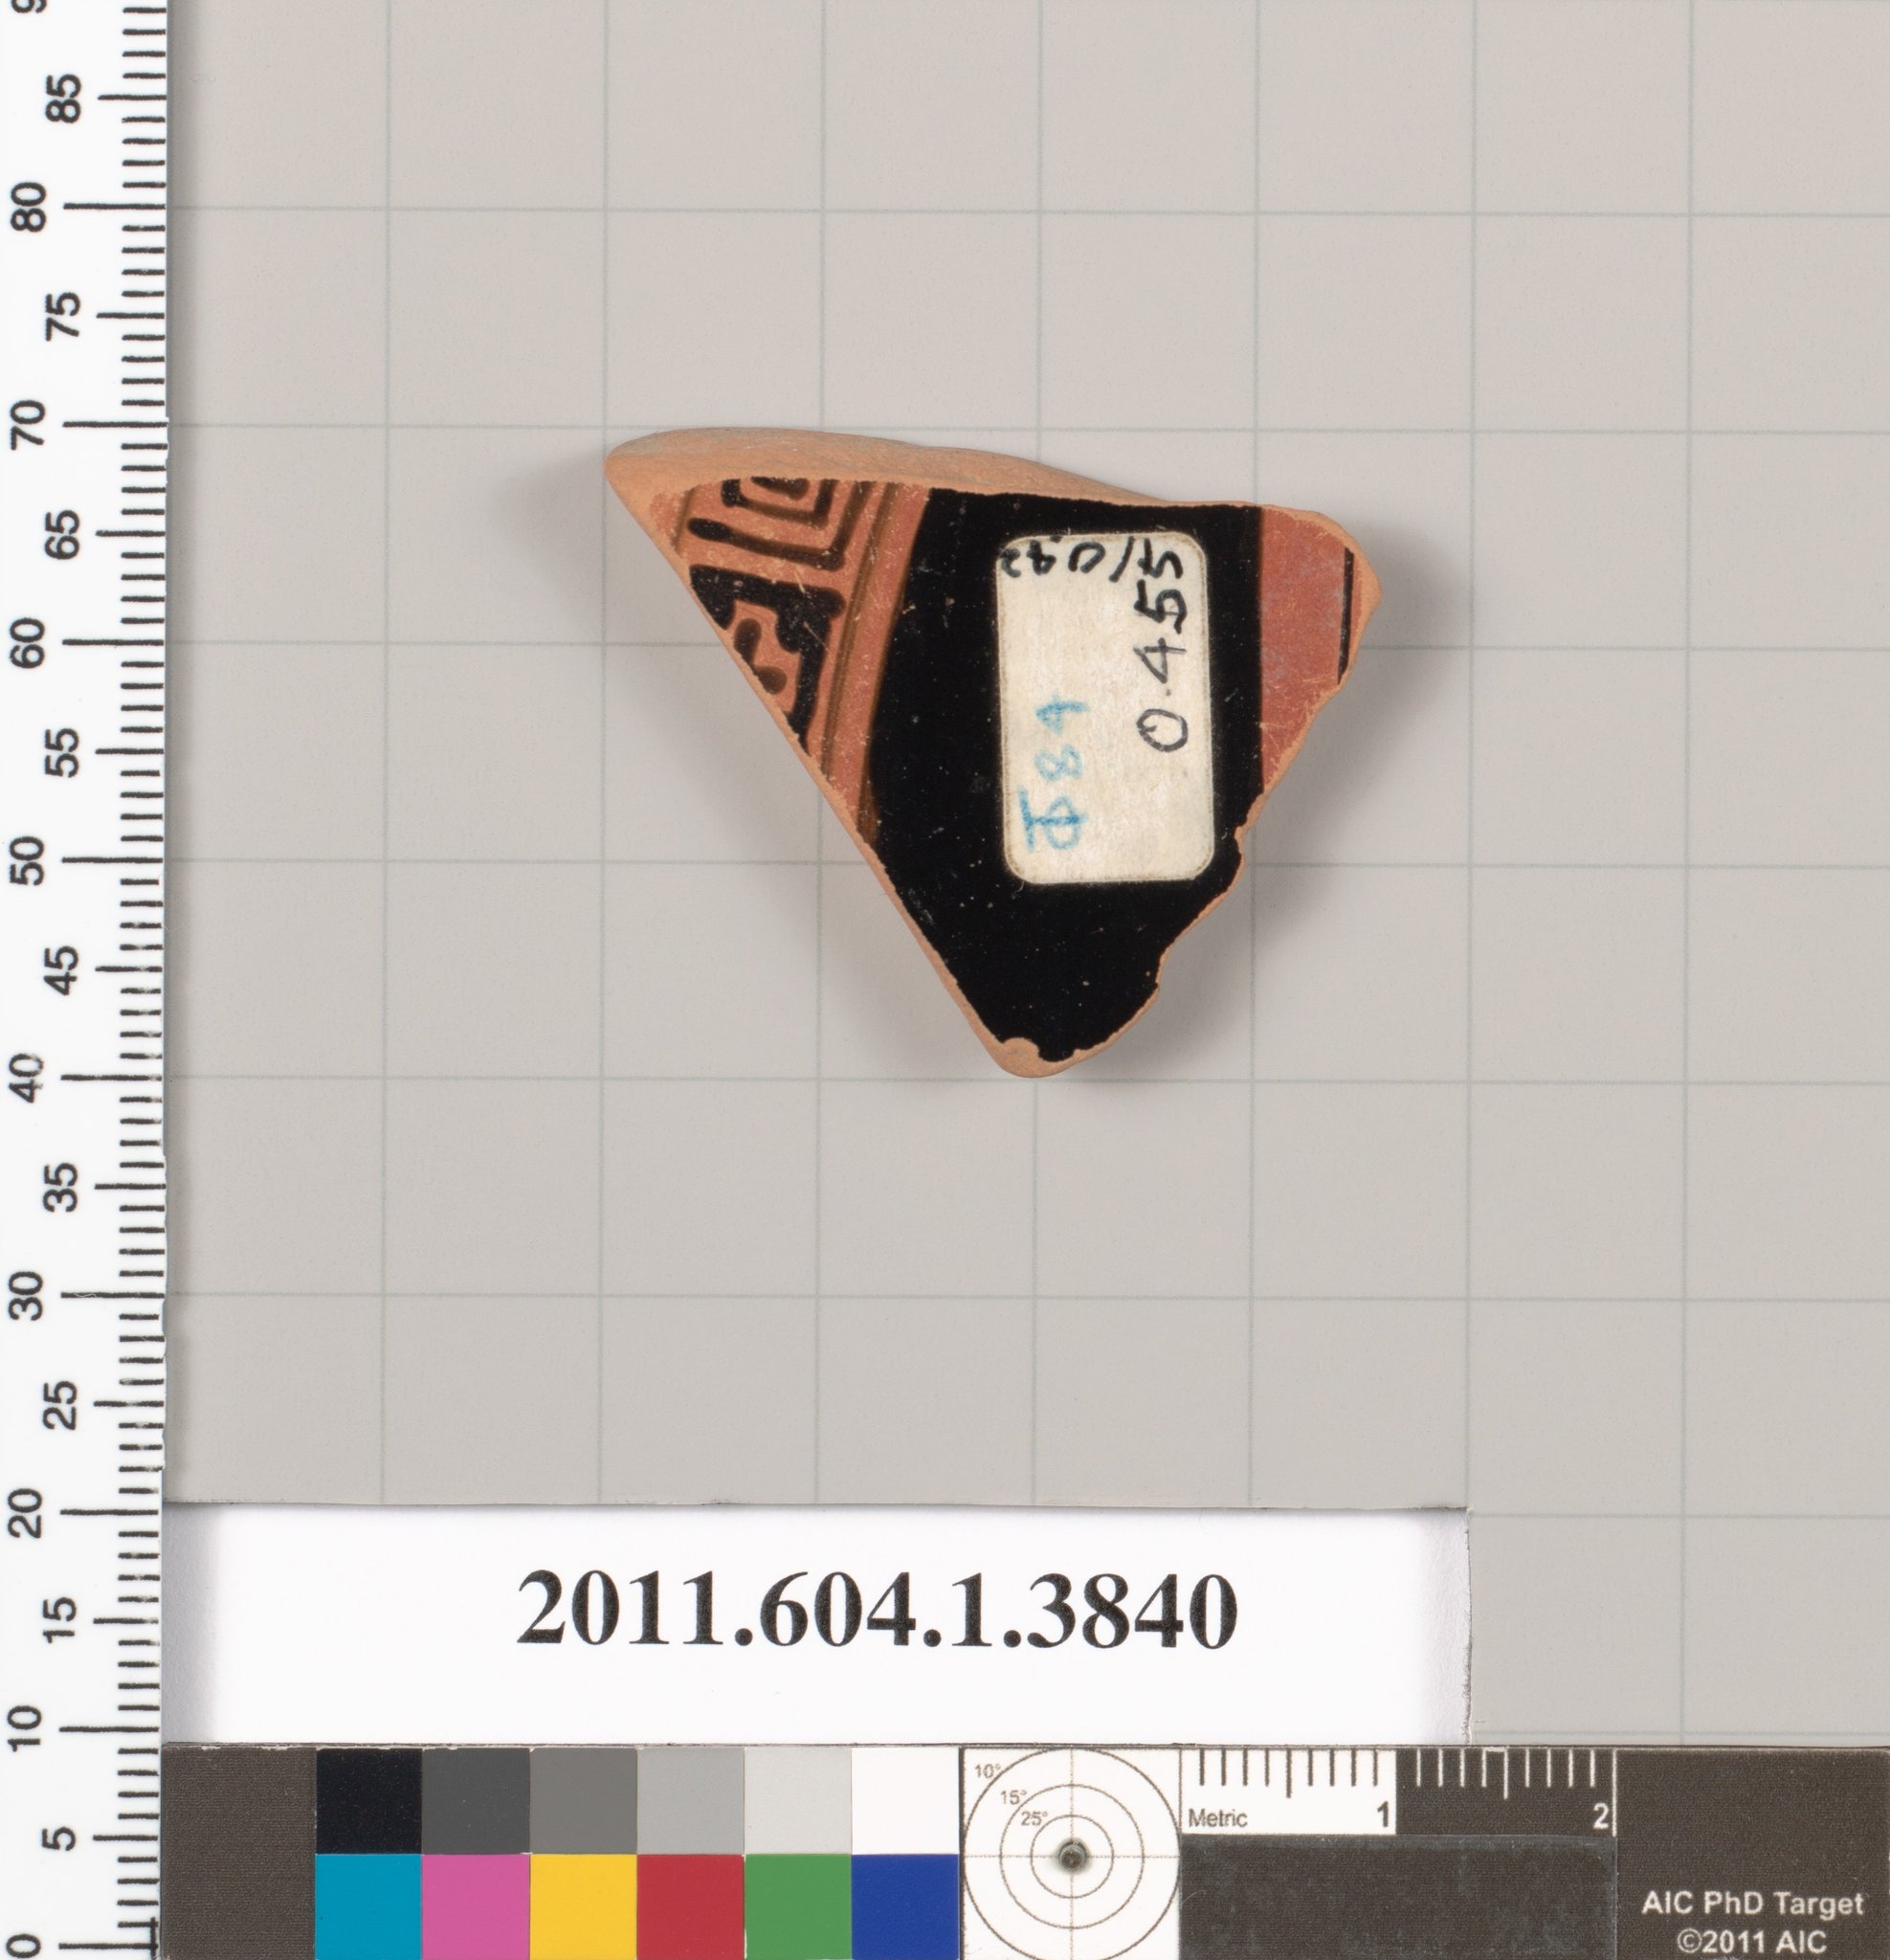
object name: kylix fragment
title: Terracotta fragment of a kylix (drinking cup)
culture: greek, attic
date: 475-451 BCE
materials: terracotta